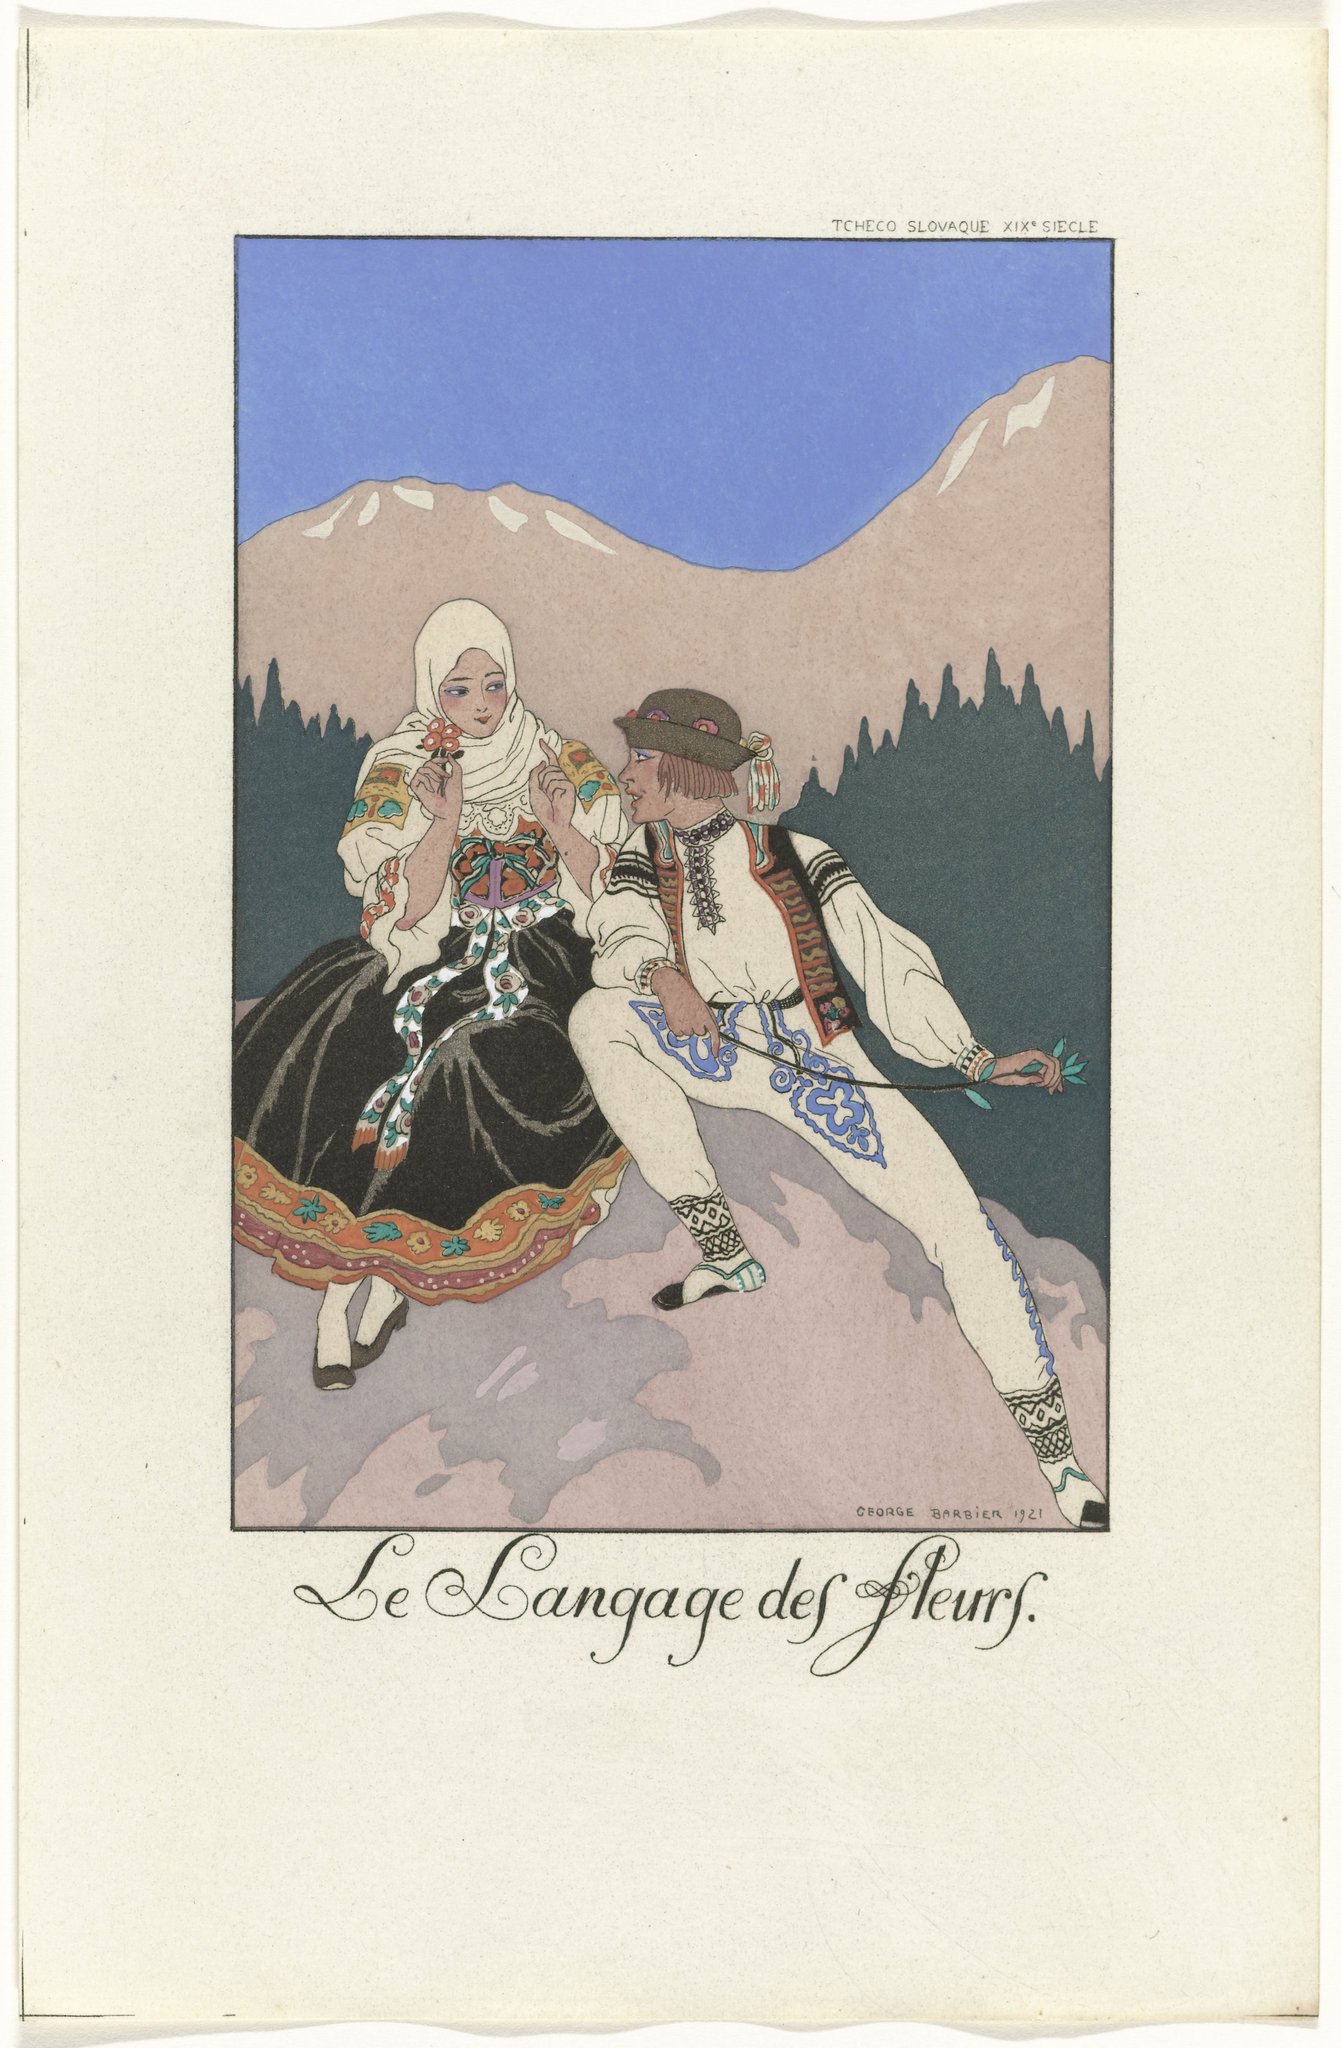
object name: fashion print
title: Falbalas et Fanfreluches: almanach des modes présentes, passées & futures pour 1922 : Le Langage des Fleurs / Tchéco-Slovaque XIXe siècle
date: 1921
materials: paper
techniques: hand coloring, lithograph, pochoir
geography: paris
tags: flowers, folk costume, regional costume (+ women's clothes), folk costume, regional costume (+ men's clothes), europeans (czechs), fashion plates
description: Een jongeman en een meisje in 19de-eeuwse Tschjechische klederdracht, zittend in een berglandschap. Prent uit de serie Falbalas & Fanfreluches (1922-1926).